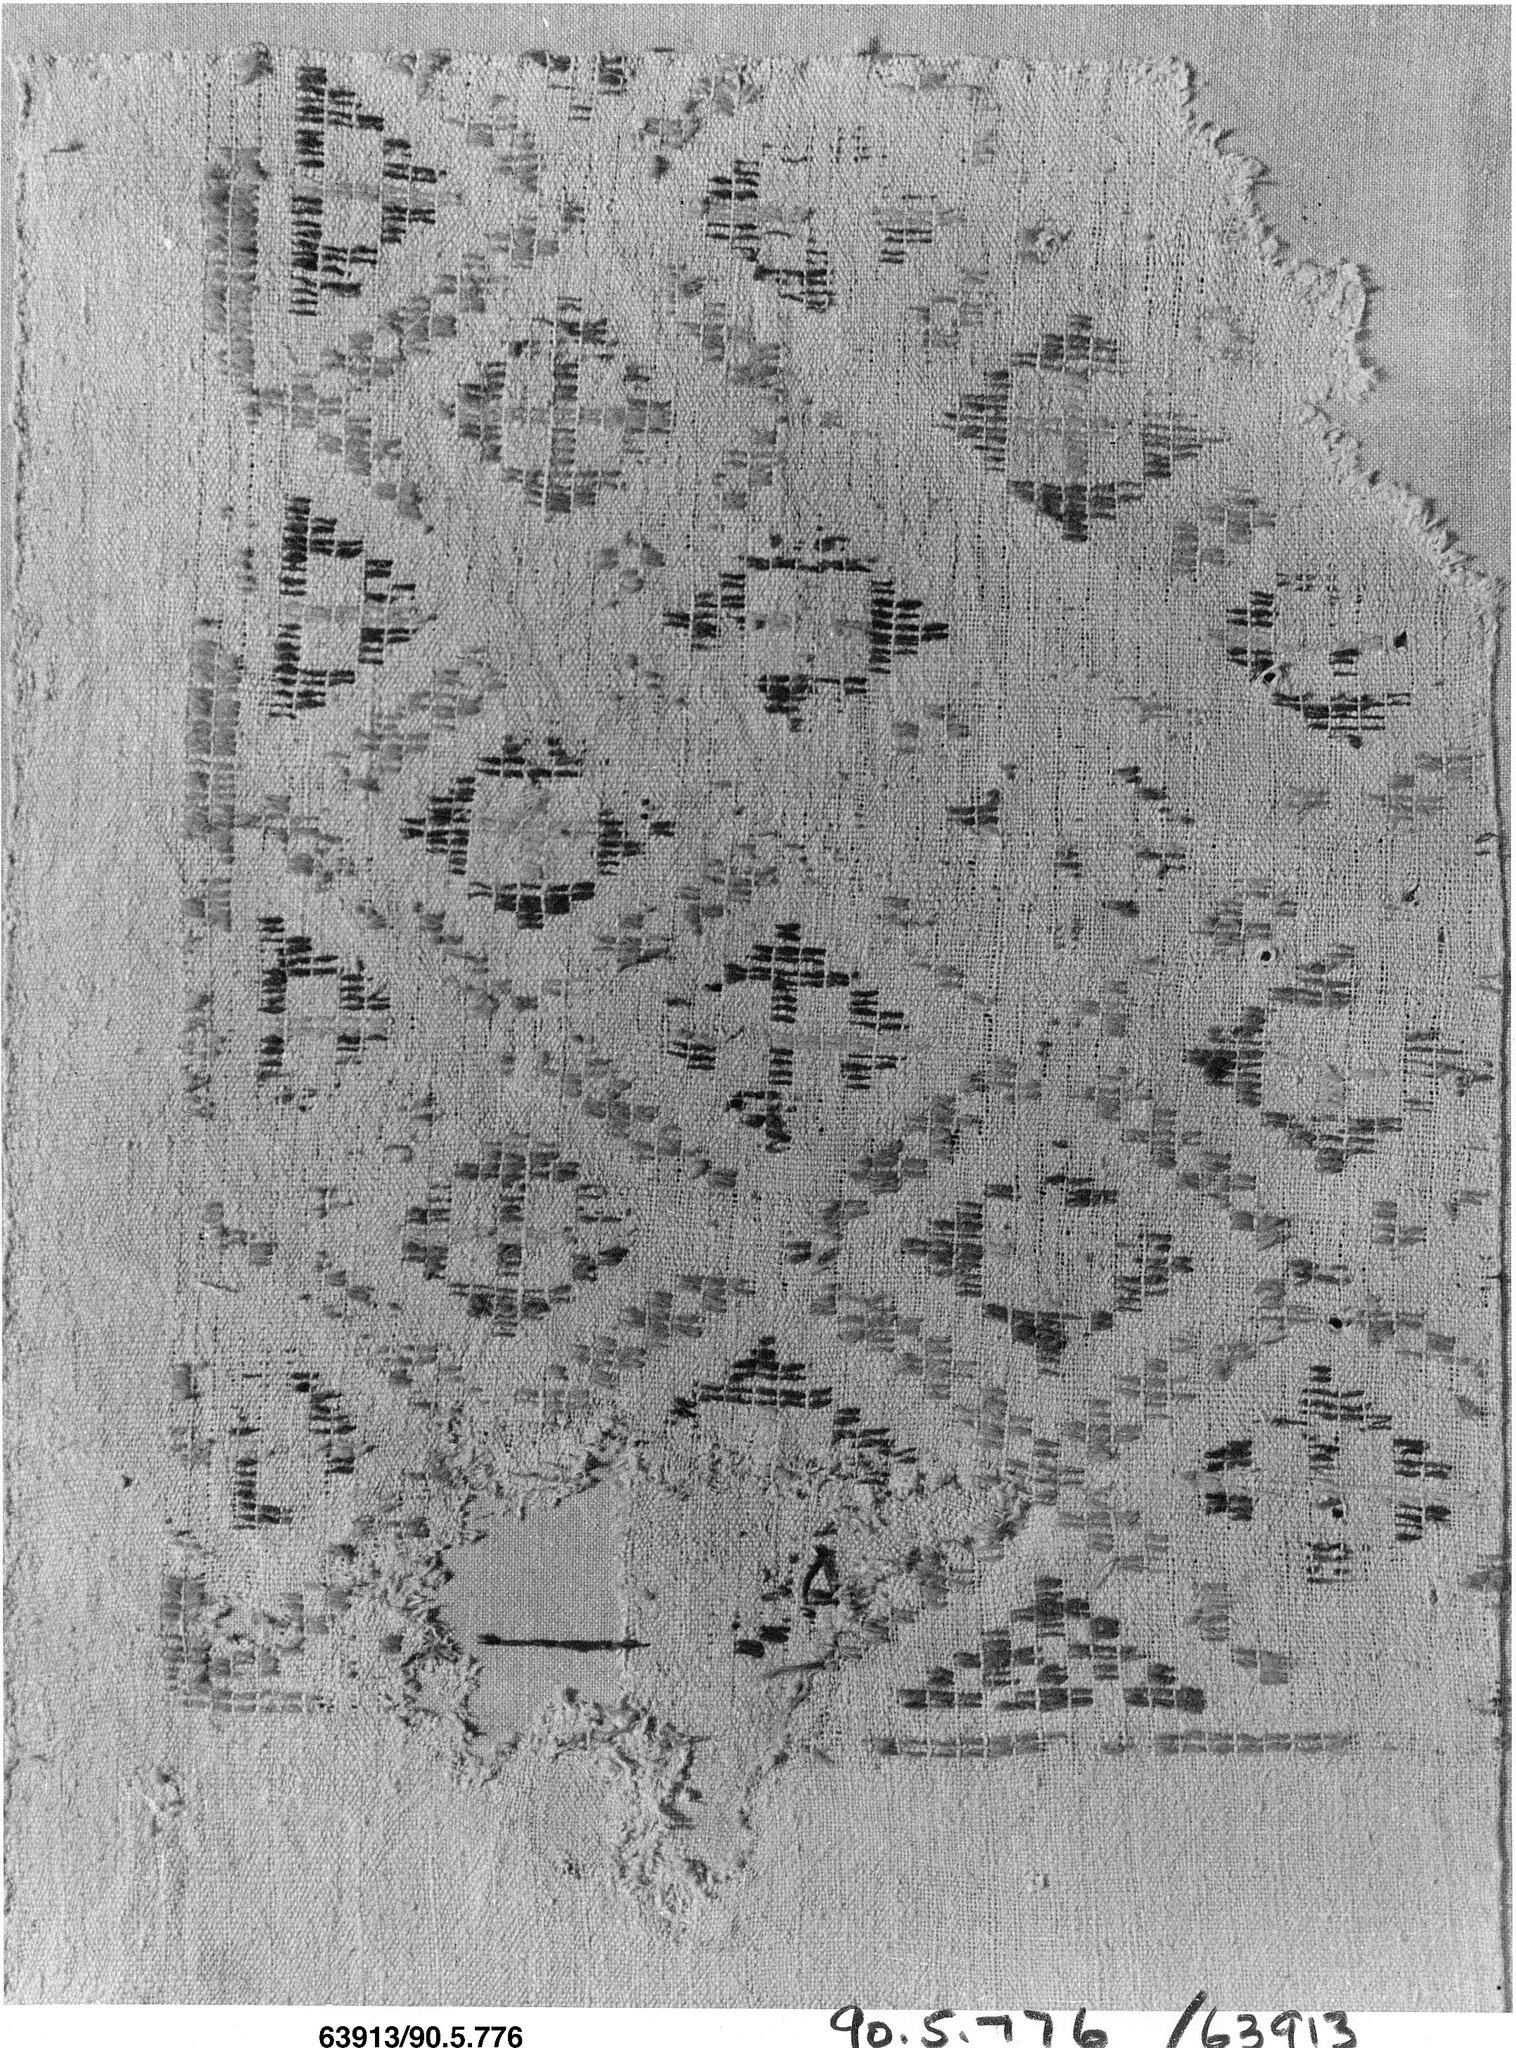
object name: textile fragment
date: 501-700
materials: linen, wool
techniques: brocade, weave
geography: egypt